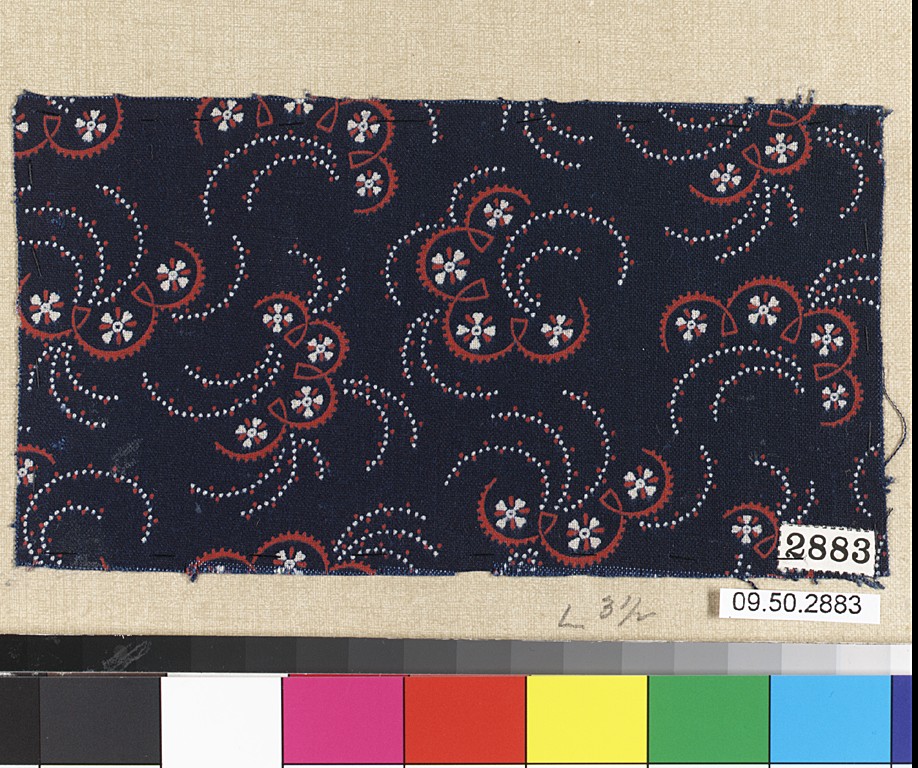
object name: piece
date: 1801-1900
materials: cotton